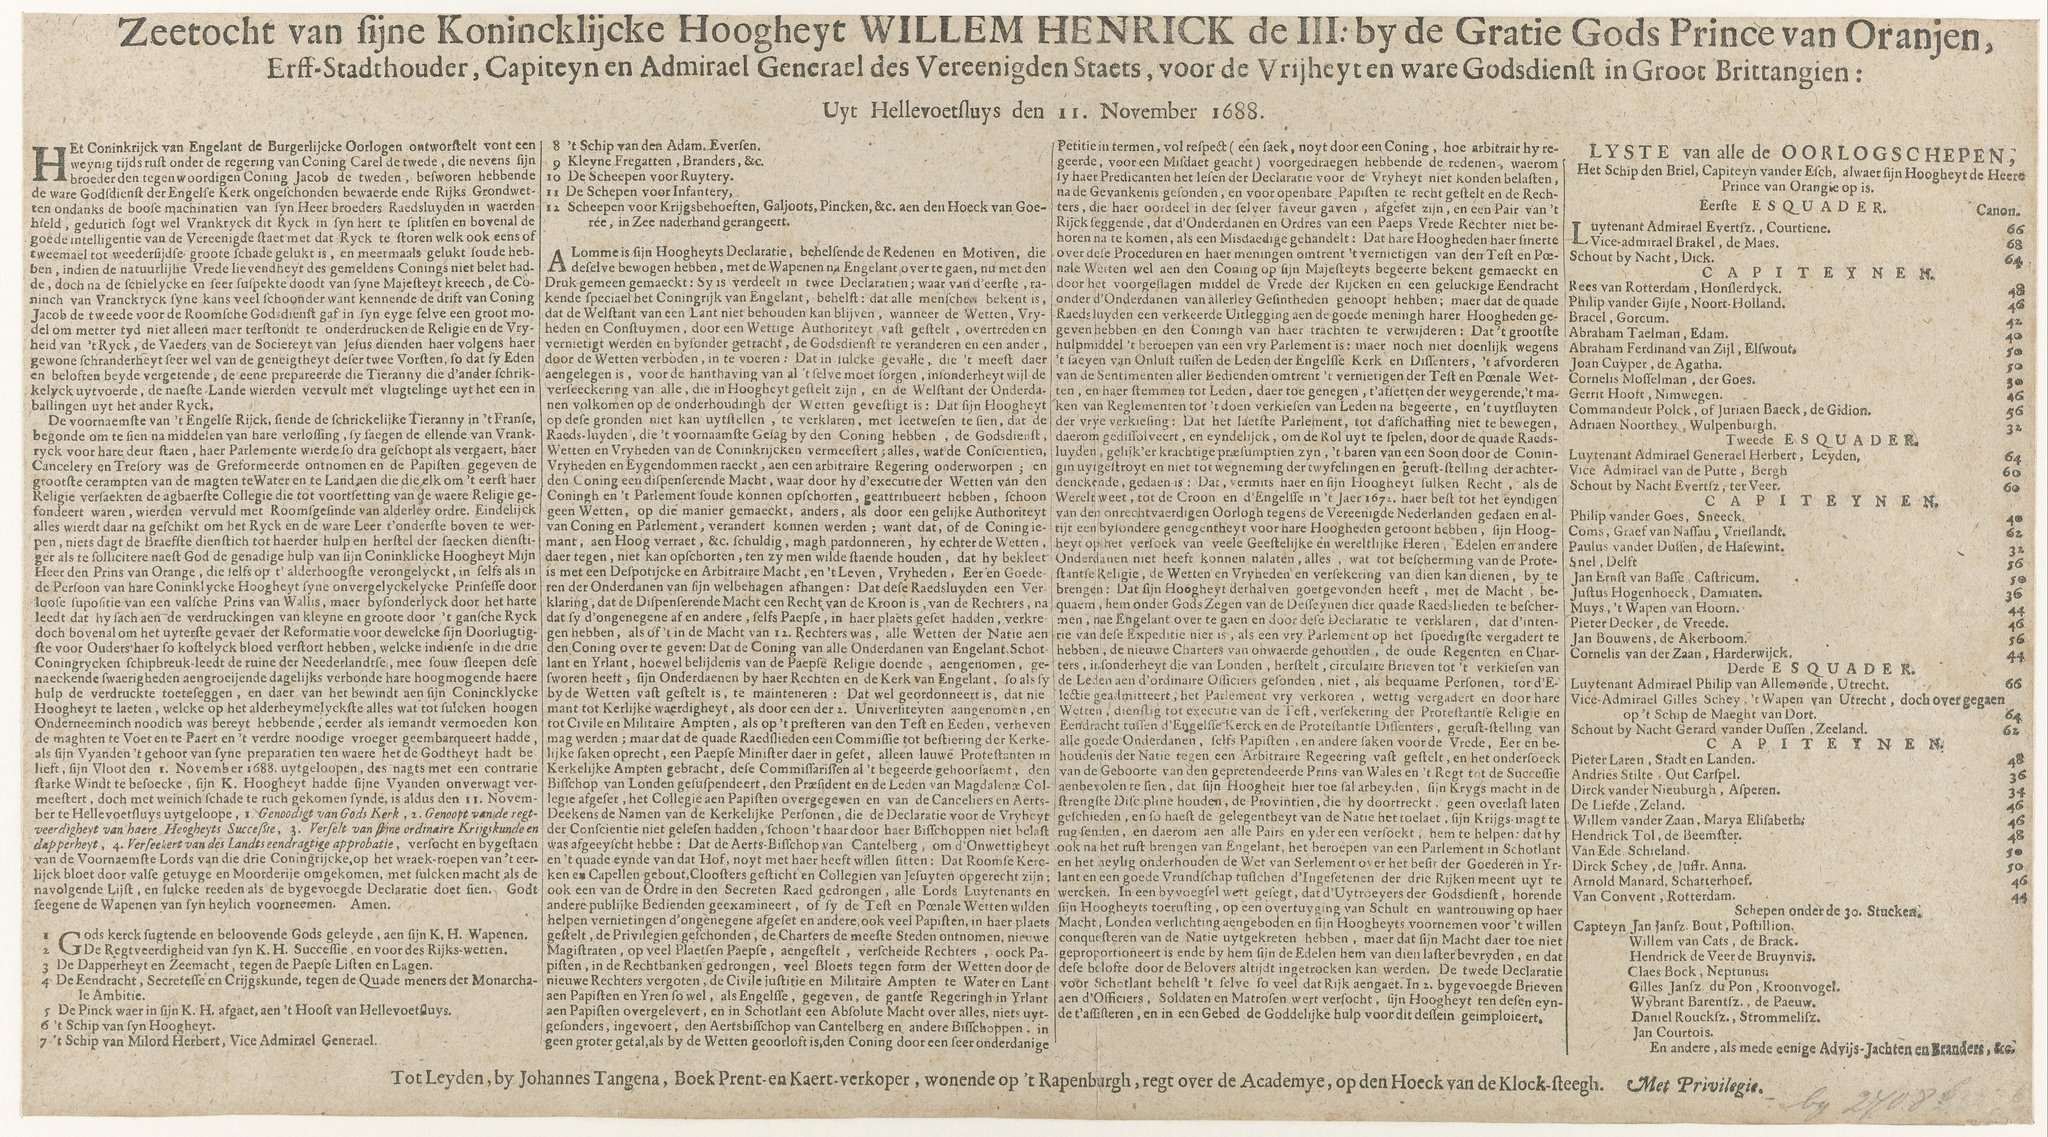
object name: text sheet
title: Zeetocht van sijne Konincklijcke Hoogheyt Willem Henrick de III; by de Gratie Gods Prince van Oranjen, Erff-Stadthouder, Capiteyn en Admirael Generael der Vereenigden Staets, voor de Vrijheyt en ware Godsdienst in Groot-Brittangien: Uyt Hellevoetsluys den 11. November 1688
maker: johannes tangena (17e eeuw)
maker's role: publisher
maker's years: -1692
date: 1688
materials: paper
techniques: letterpress printing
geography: leiden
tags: the hague, william iii (prince of orange and king of england, scotland, and ireland), hellevoetsluis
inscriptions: collector's mark: ‘RIJKSMUSEUM AMSTERDAM’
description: Tekstblad met een beschrijving van de gebeurtenissen, de legenda van de cijfers 1-12 en een lijst van de schepen die deel uit maken van de vloot, in 4 kolommen in het Nederlands. Tekstblad behorend bij de prent met Vlootschouw bij het vertrek van Willem III vanuit Hellevoetsluis naar Engeland, 11 november 1688. Zie de bijbehorende prent.